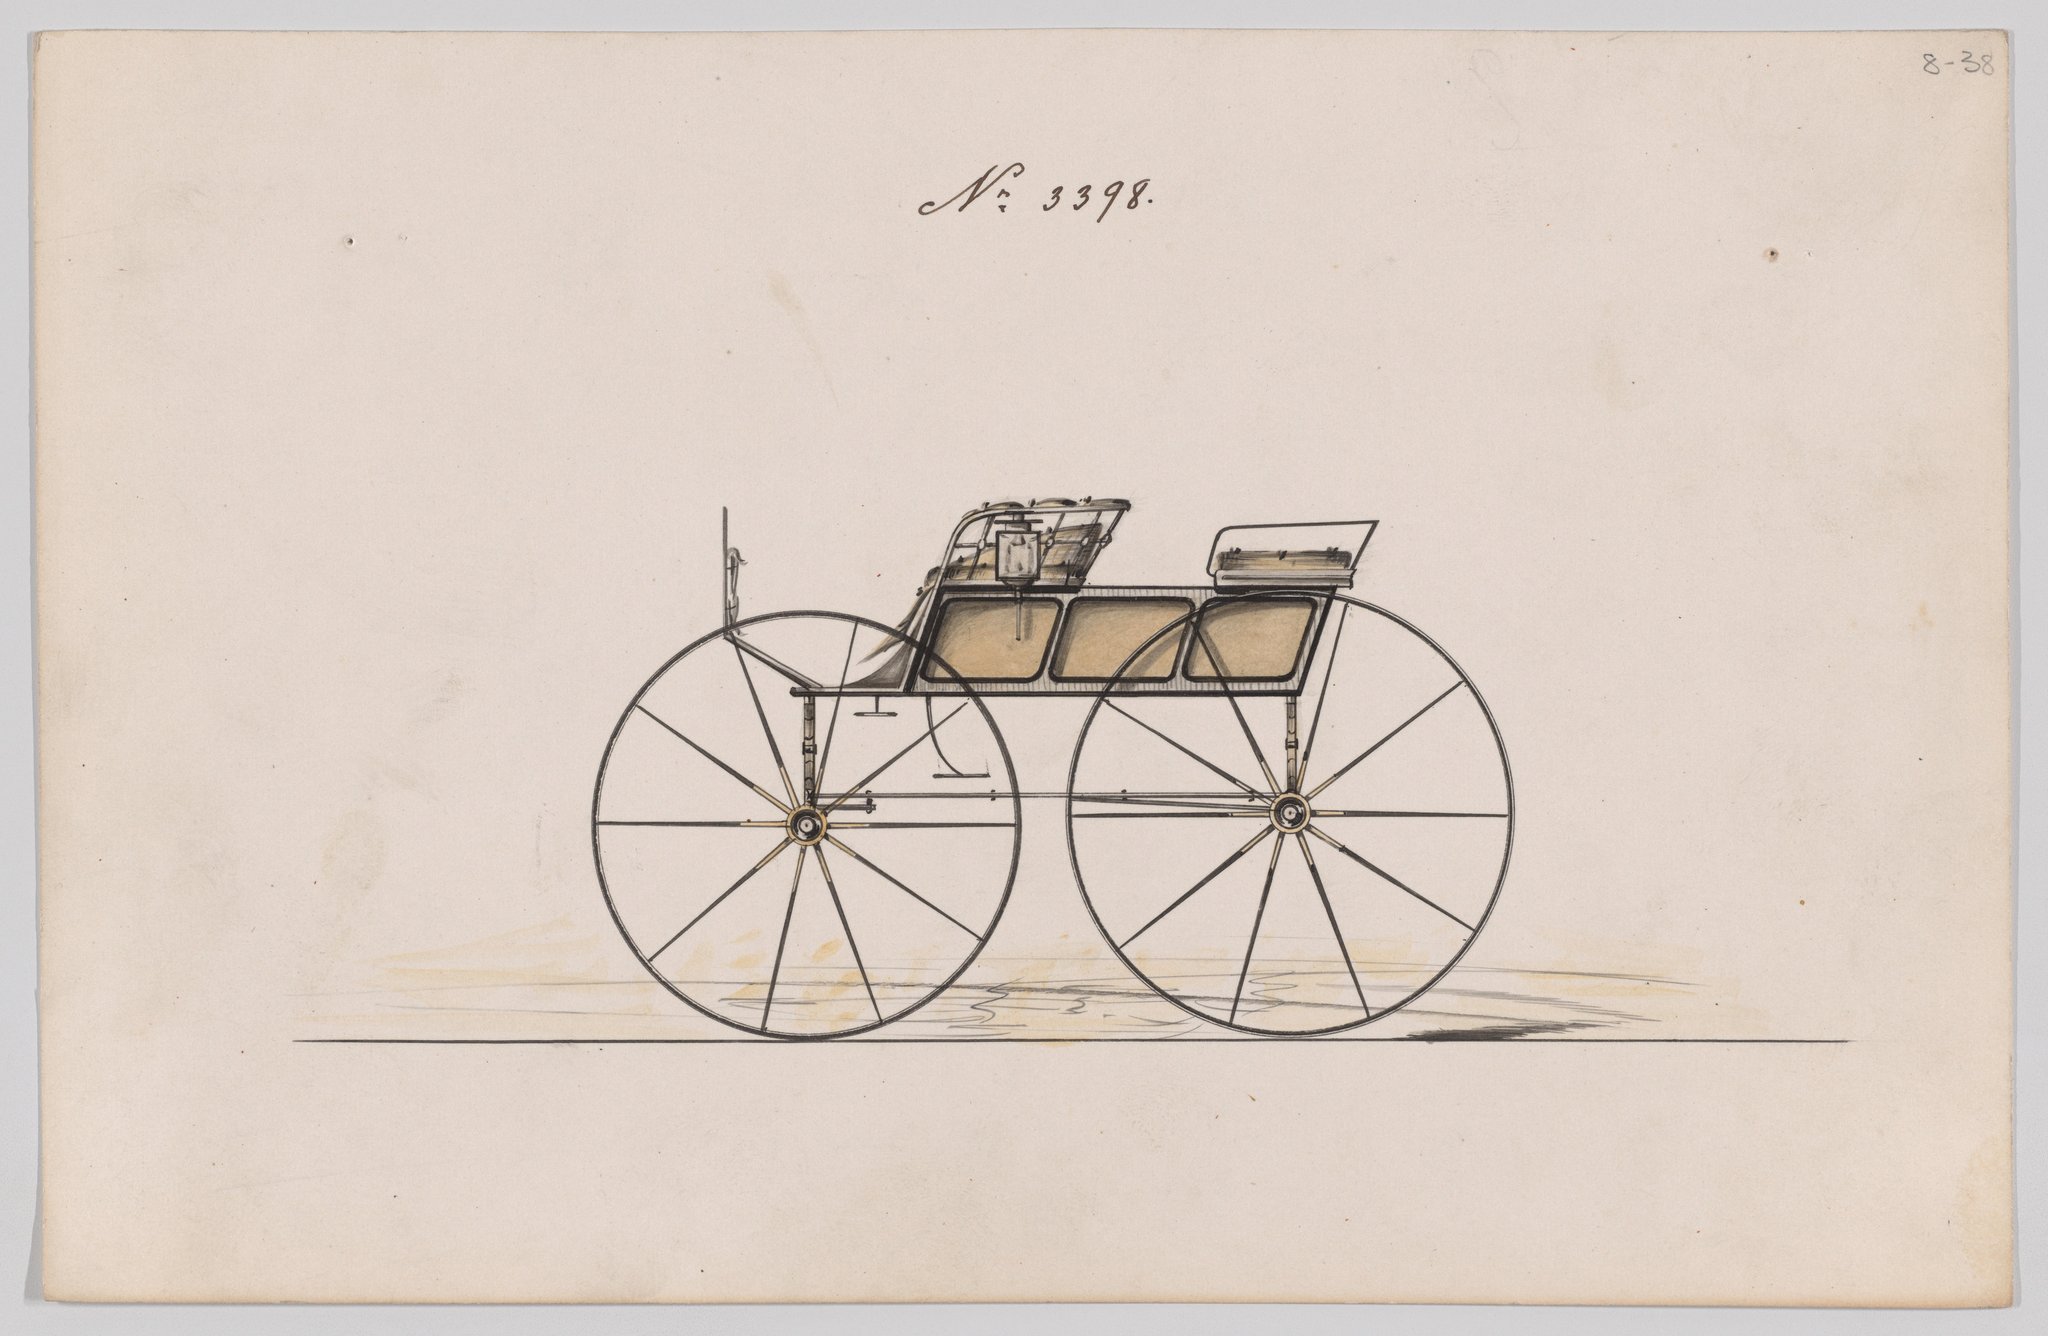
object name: drawing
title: Design for 4 seat Phaeton, no top, no. 3398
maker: brewster & co.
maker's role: manufacturer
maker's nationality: american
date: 1878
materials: gouache, gum arabic, ink, watercolor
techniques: pen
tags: carriages